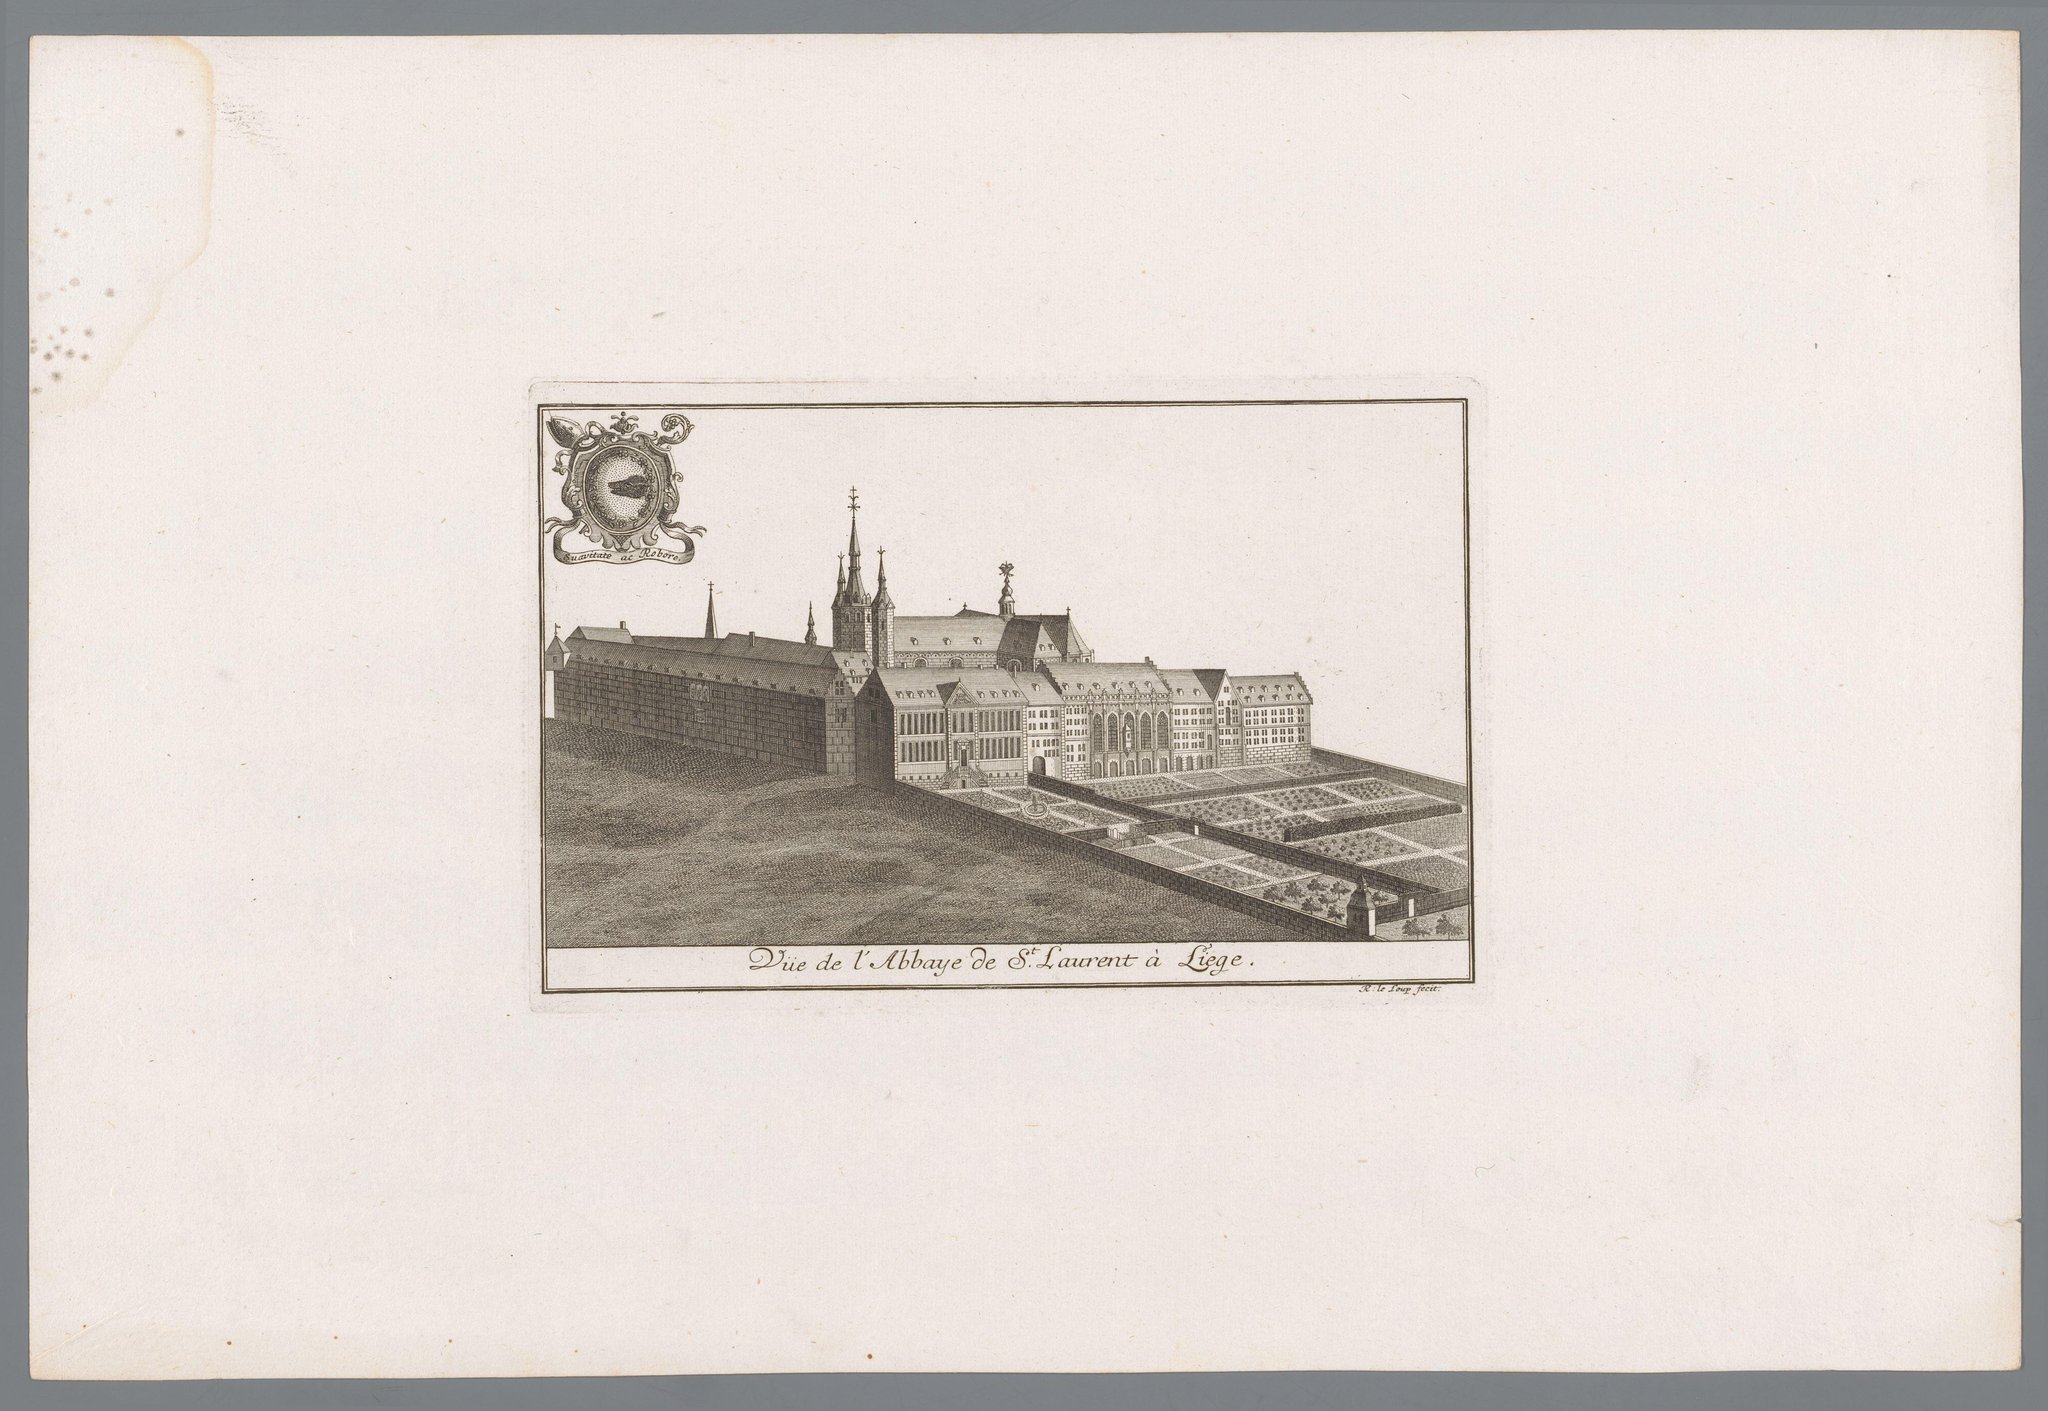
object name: print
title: Gezicht op de Sint-Laurentiusabdij in Luik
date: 1738-1744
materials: paper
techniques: engraving, etching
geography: liège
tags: church (exterior), liège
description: Prent uit: Johanne de Saumery, Alexandre de et al. Les délices du païs de Liège, ou description géographique, topographique et chorographique des monumes sacrés et profanes (...). 5 dln. Luik: Everard Kints, 1738-1744, dl. 1, p. 297.